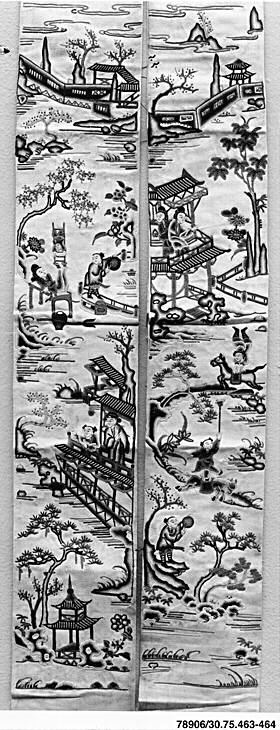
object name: sleeve band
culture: chinese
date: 1801-1900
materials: silk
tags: human figures,animals,landscapes